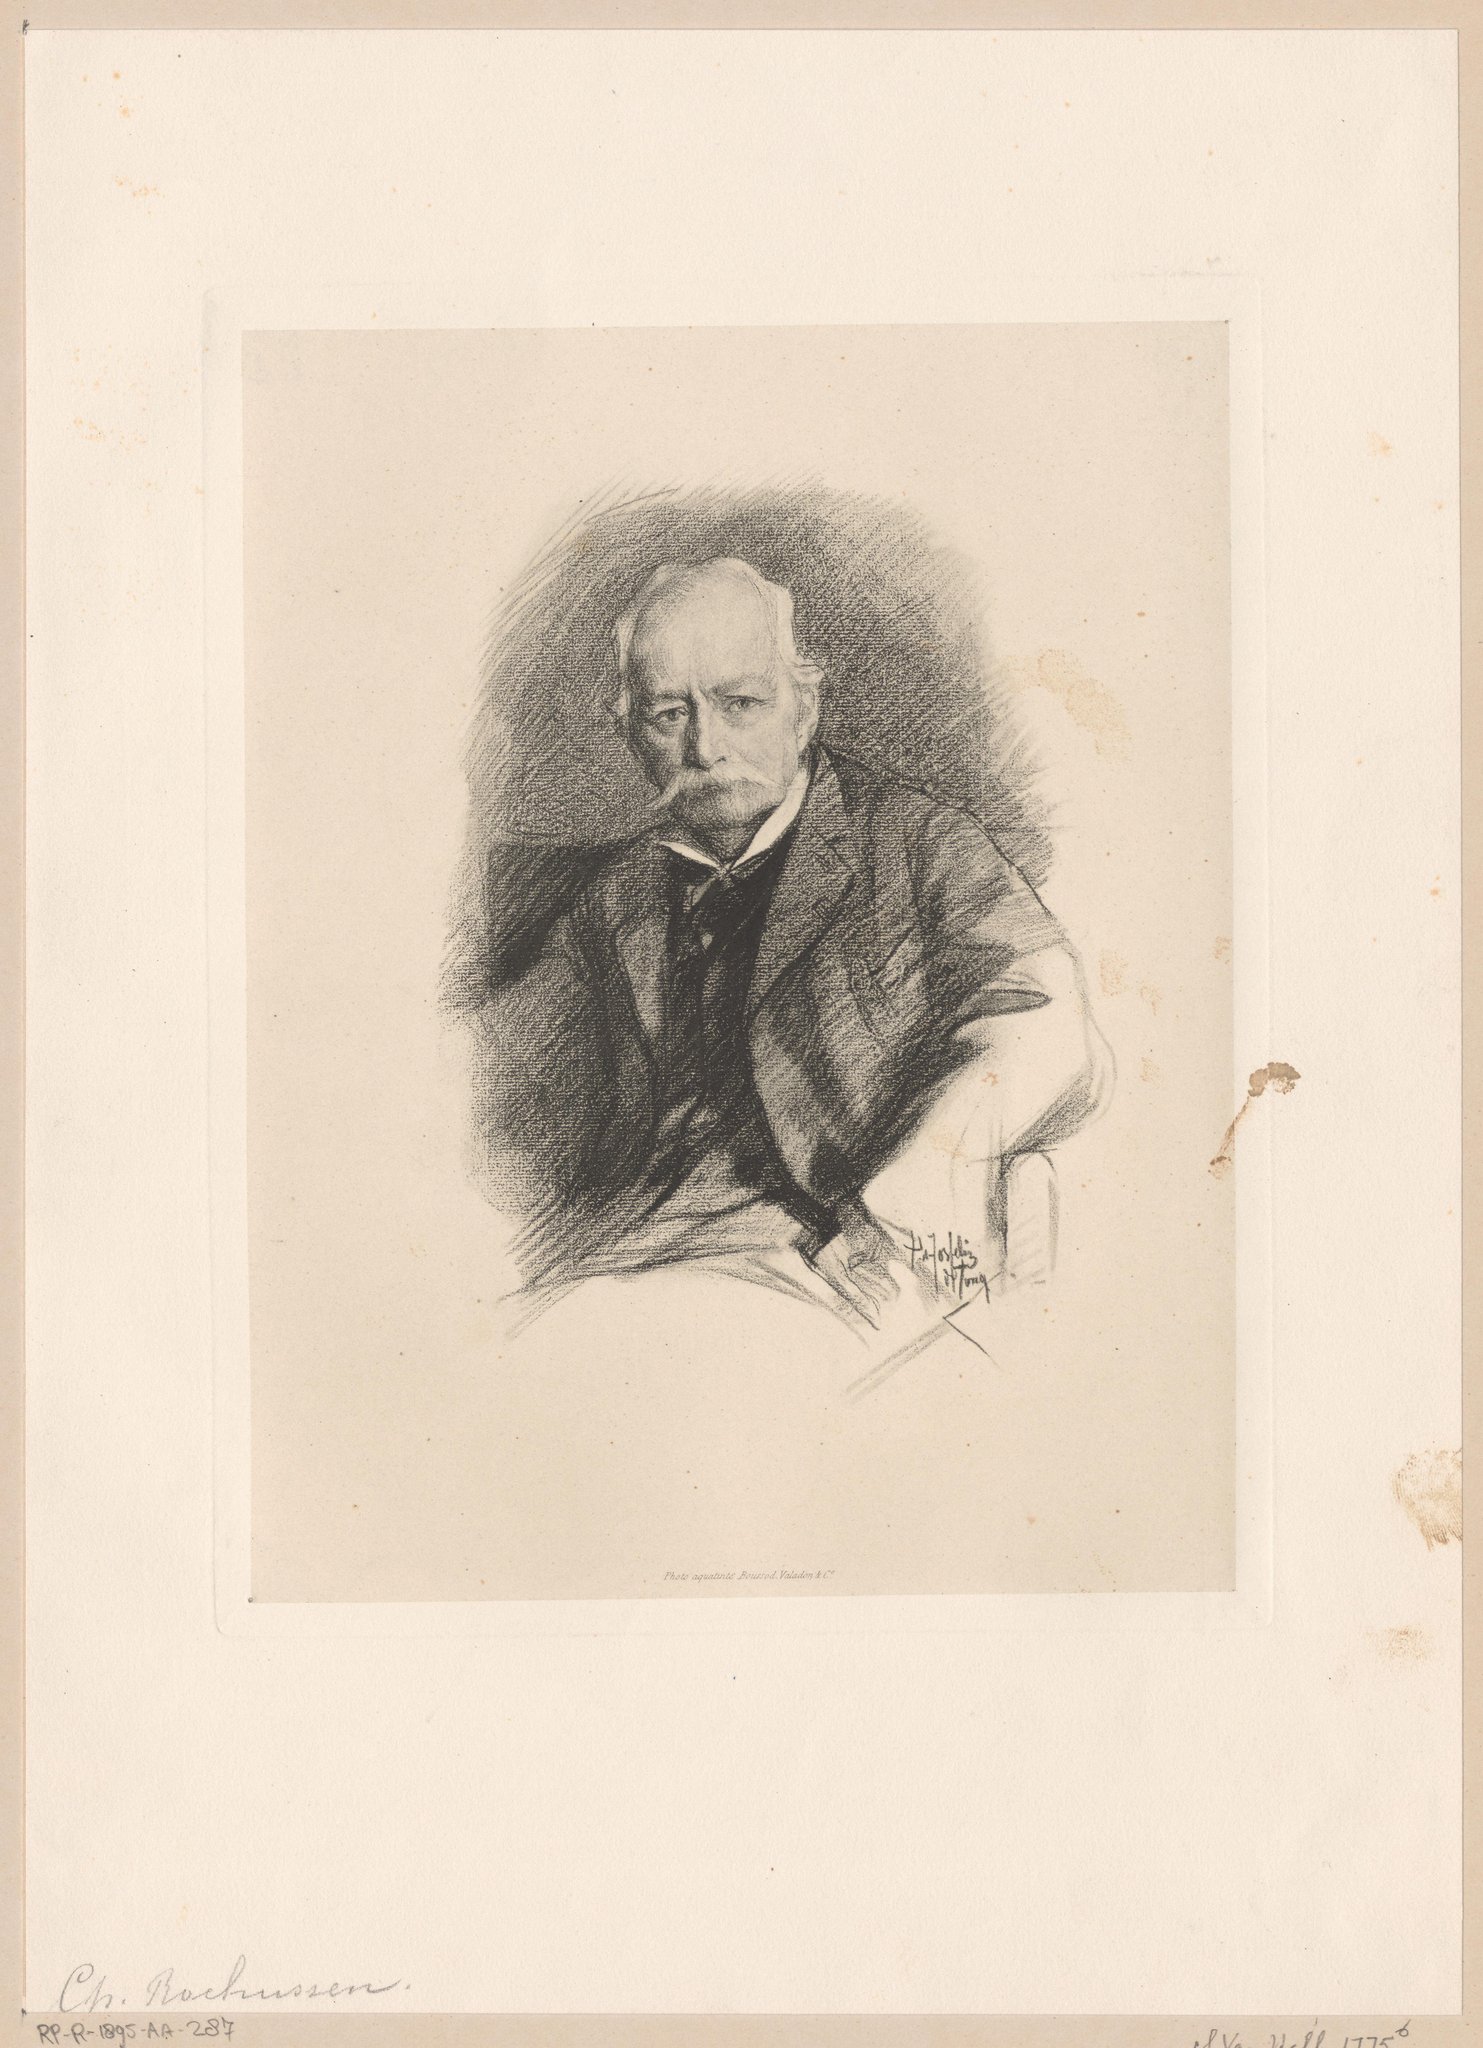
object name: photomechanical print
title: Portret van Charles Rochussen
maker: pieter de josselin de jong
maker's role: draughtsman, painter, print maker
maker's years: 1861-1906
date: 1871-1906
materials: paper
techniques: photoaquatint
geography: the hague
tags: rotterdam, painter, print maker, draughtsman, charles rochussen, historical persons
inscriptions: collector's mark: Lugt 2228